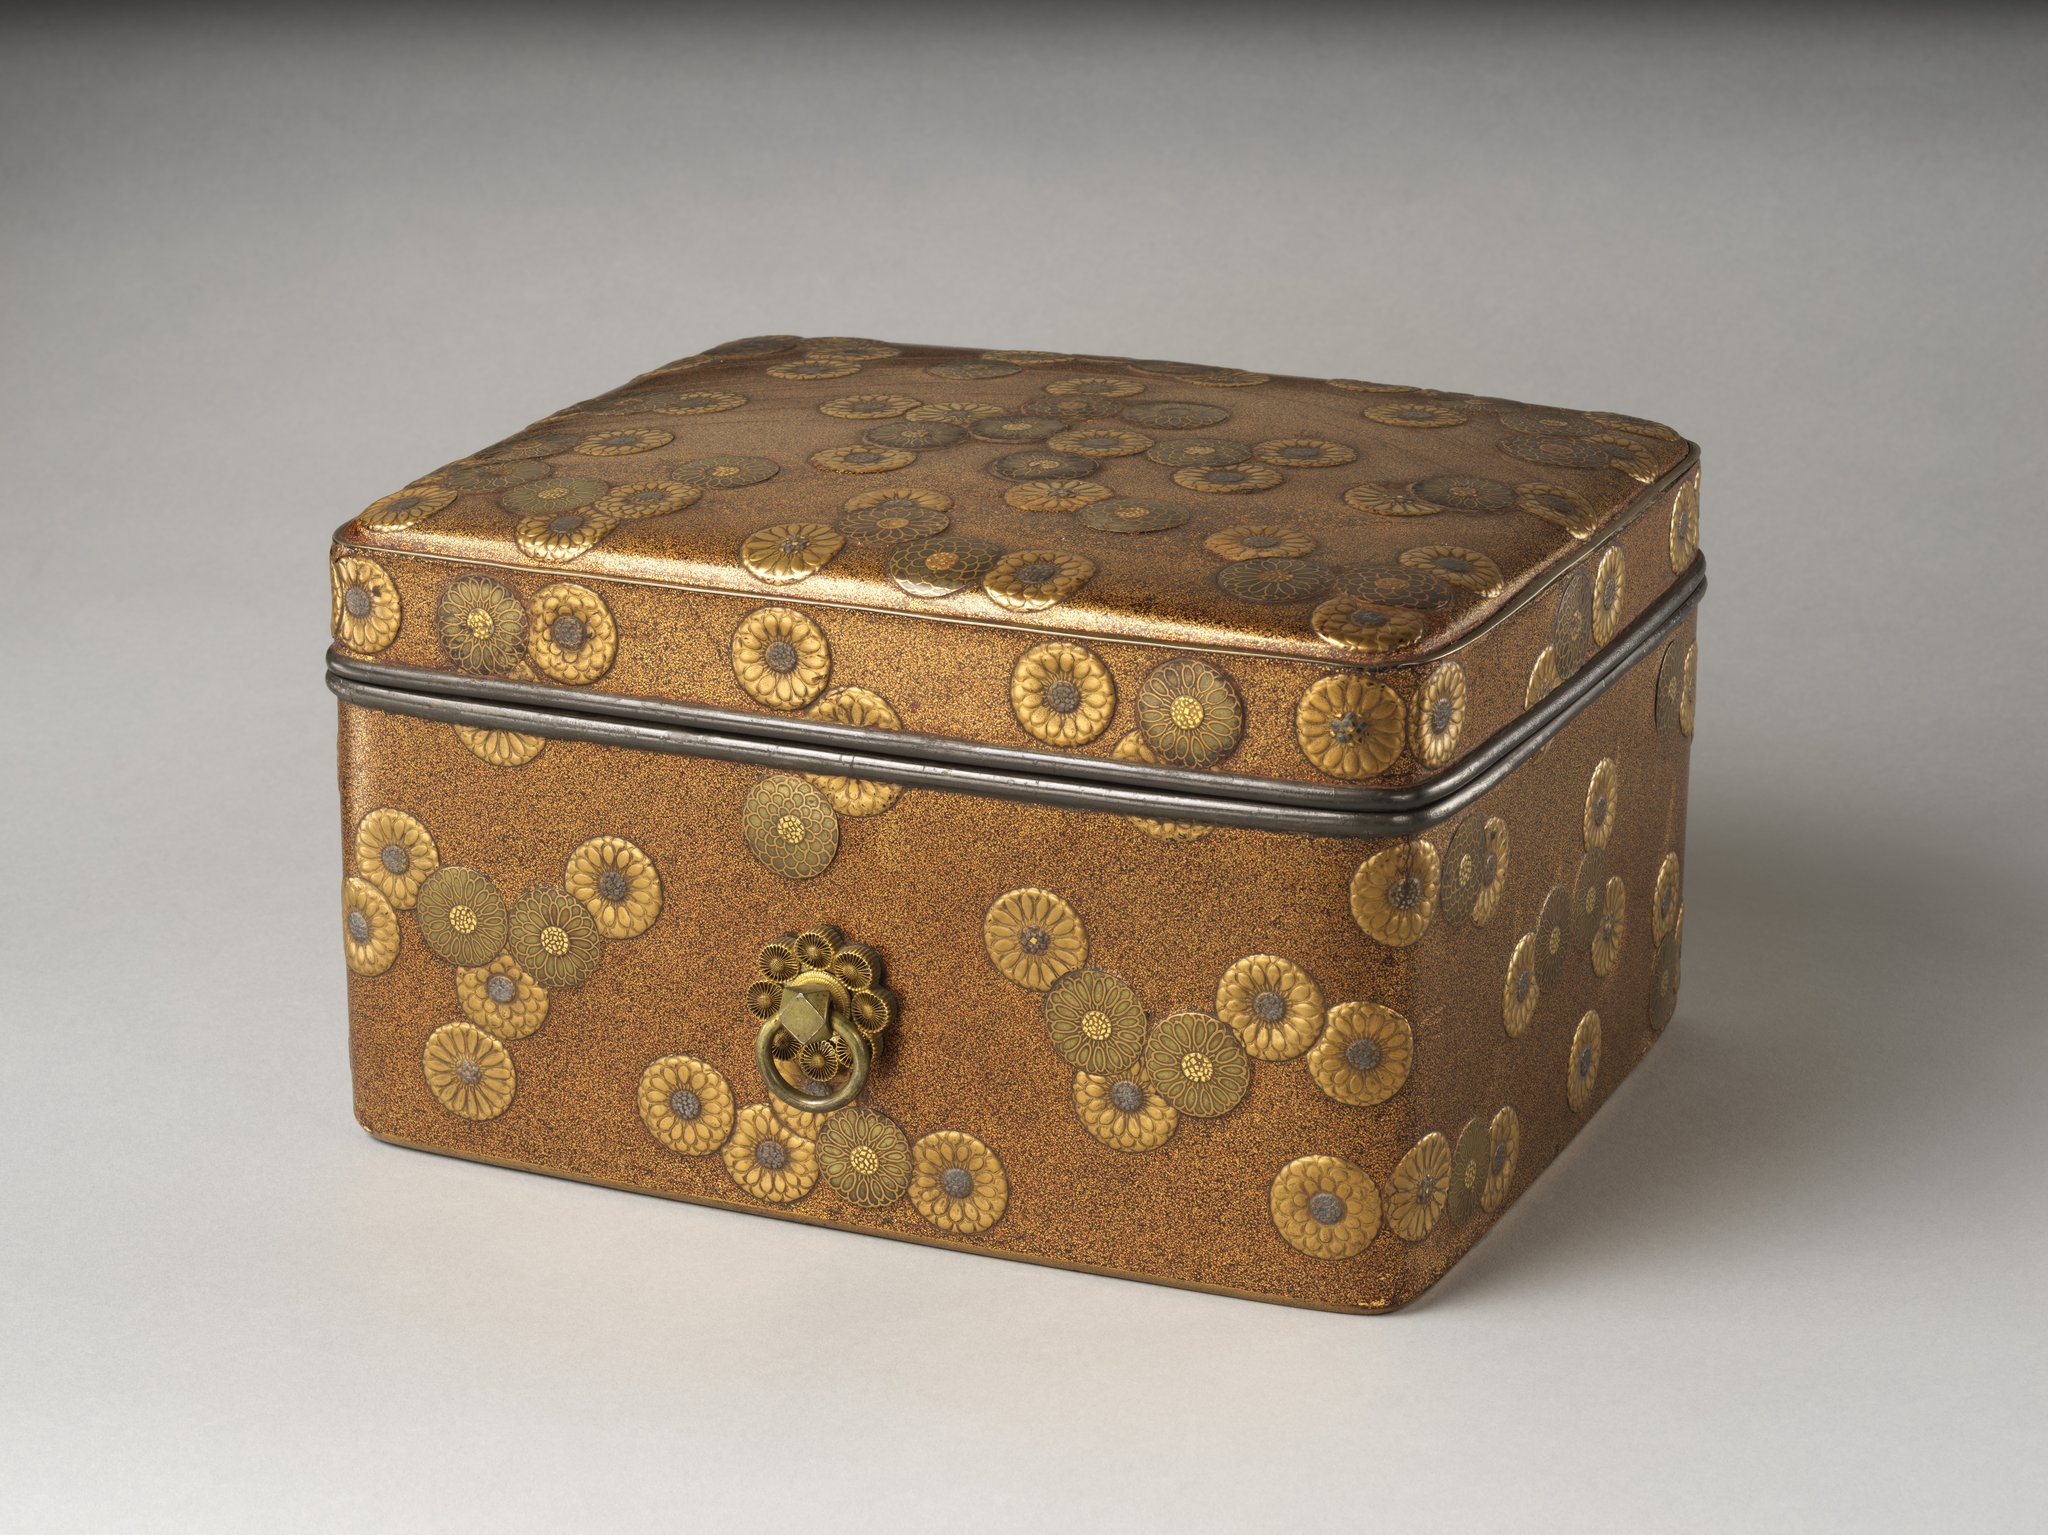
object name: cosmetic box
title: Cosmetic Box (Tebako) with Chrysanthemum Flowers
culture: japanese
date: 1401-1450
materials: foil, gilt bronze, gold, silver, wood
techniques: hiramakie, lacquer, maki-e